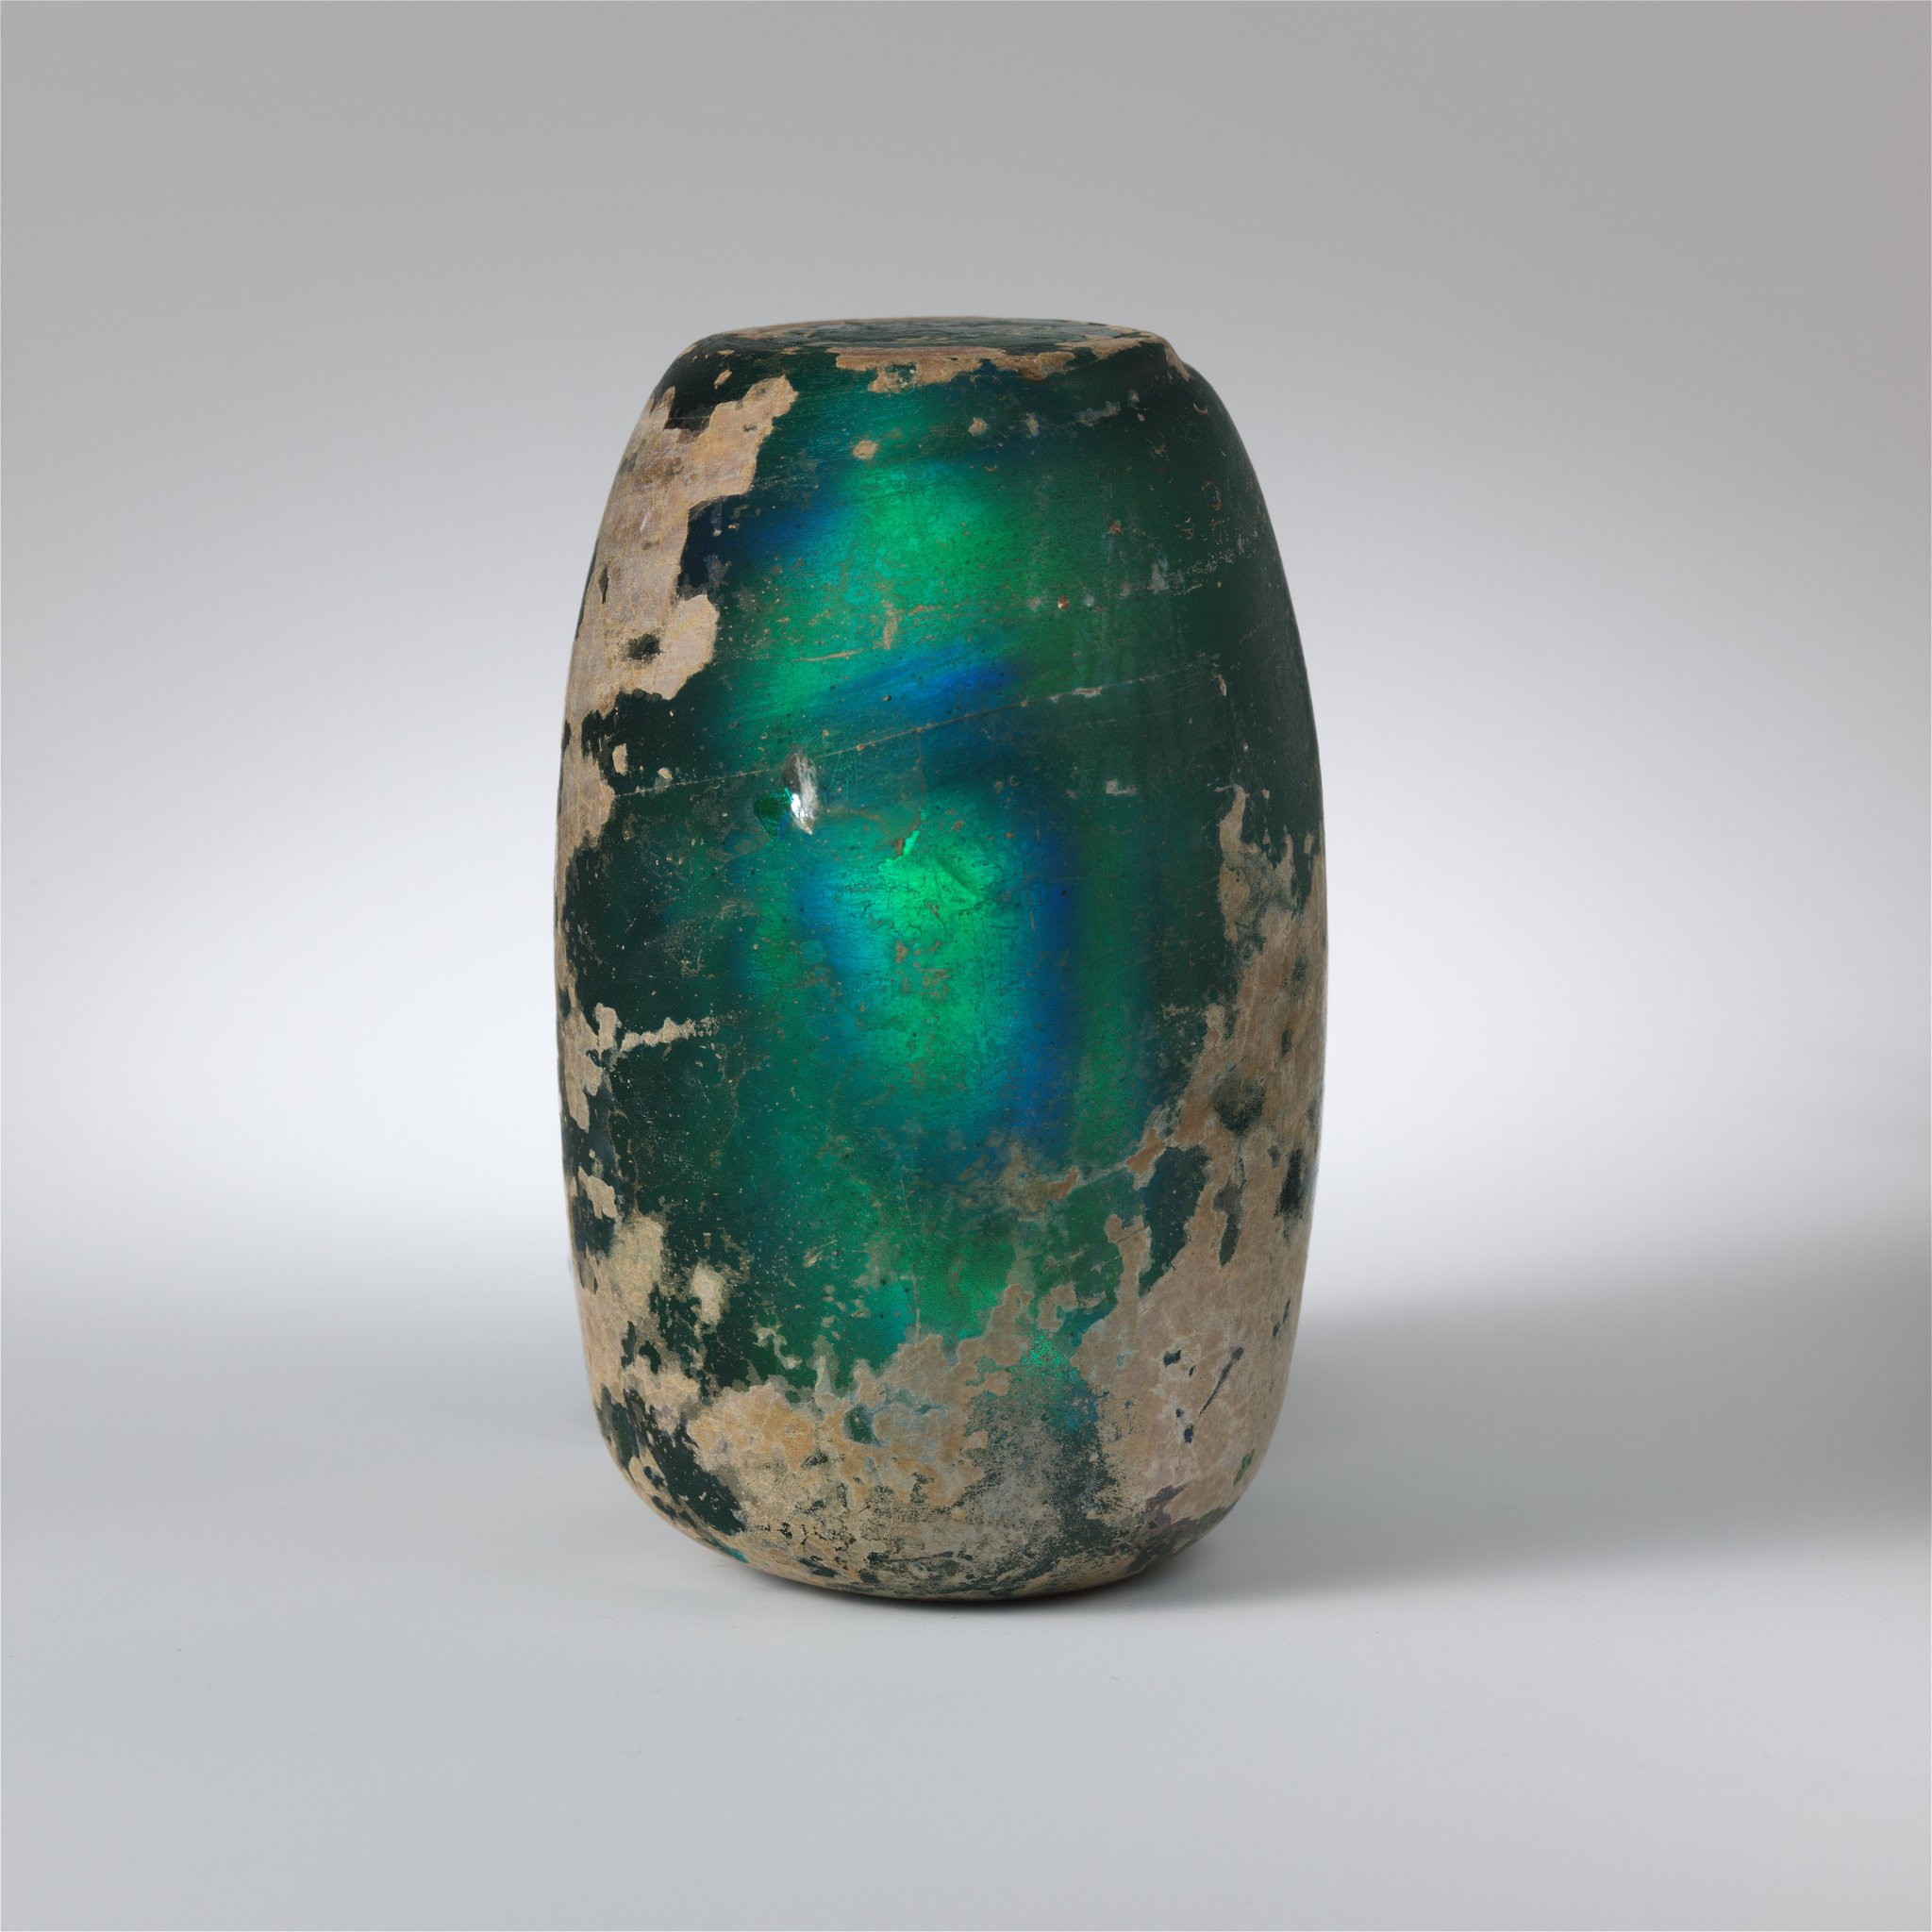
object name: weight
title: Glass weight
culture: roman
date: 1-100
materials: glass